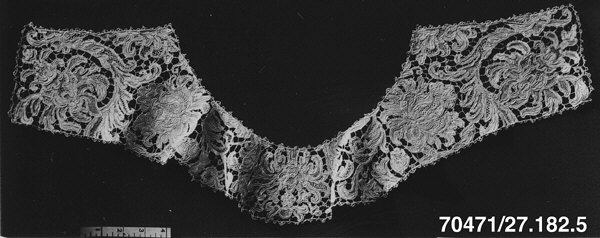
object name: collar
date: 1601-1700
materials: lace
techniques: gros point, lace